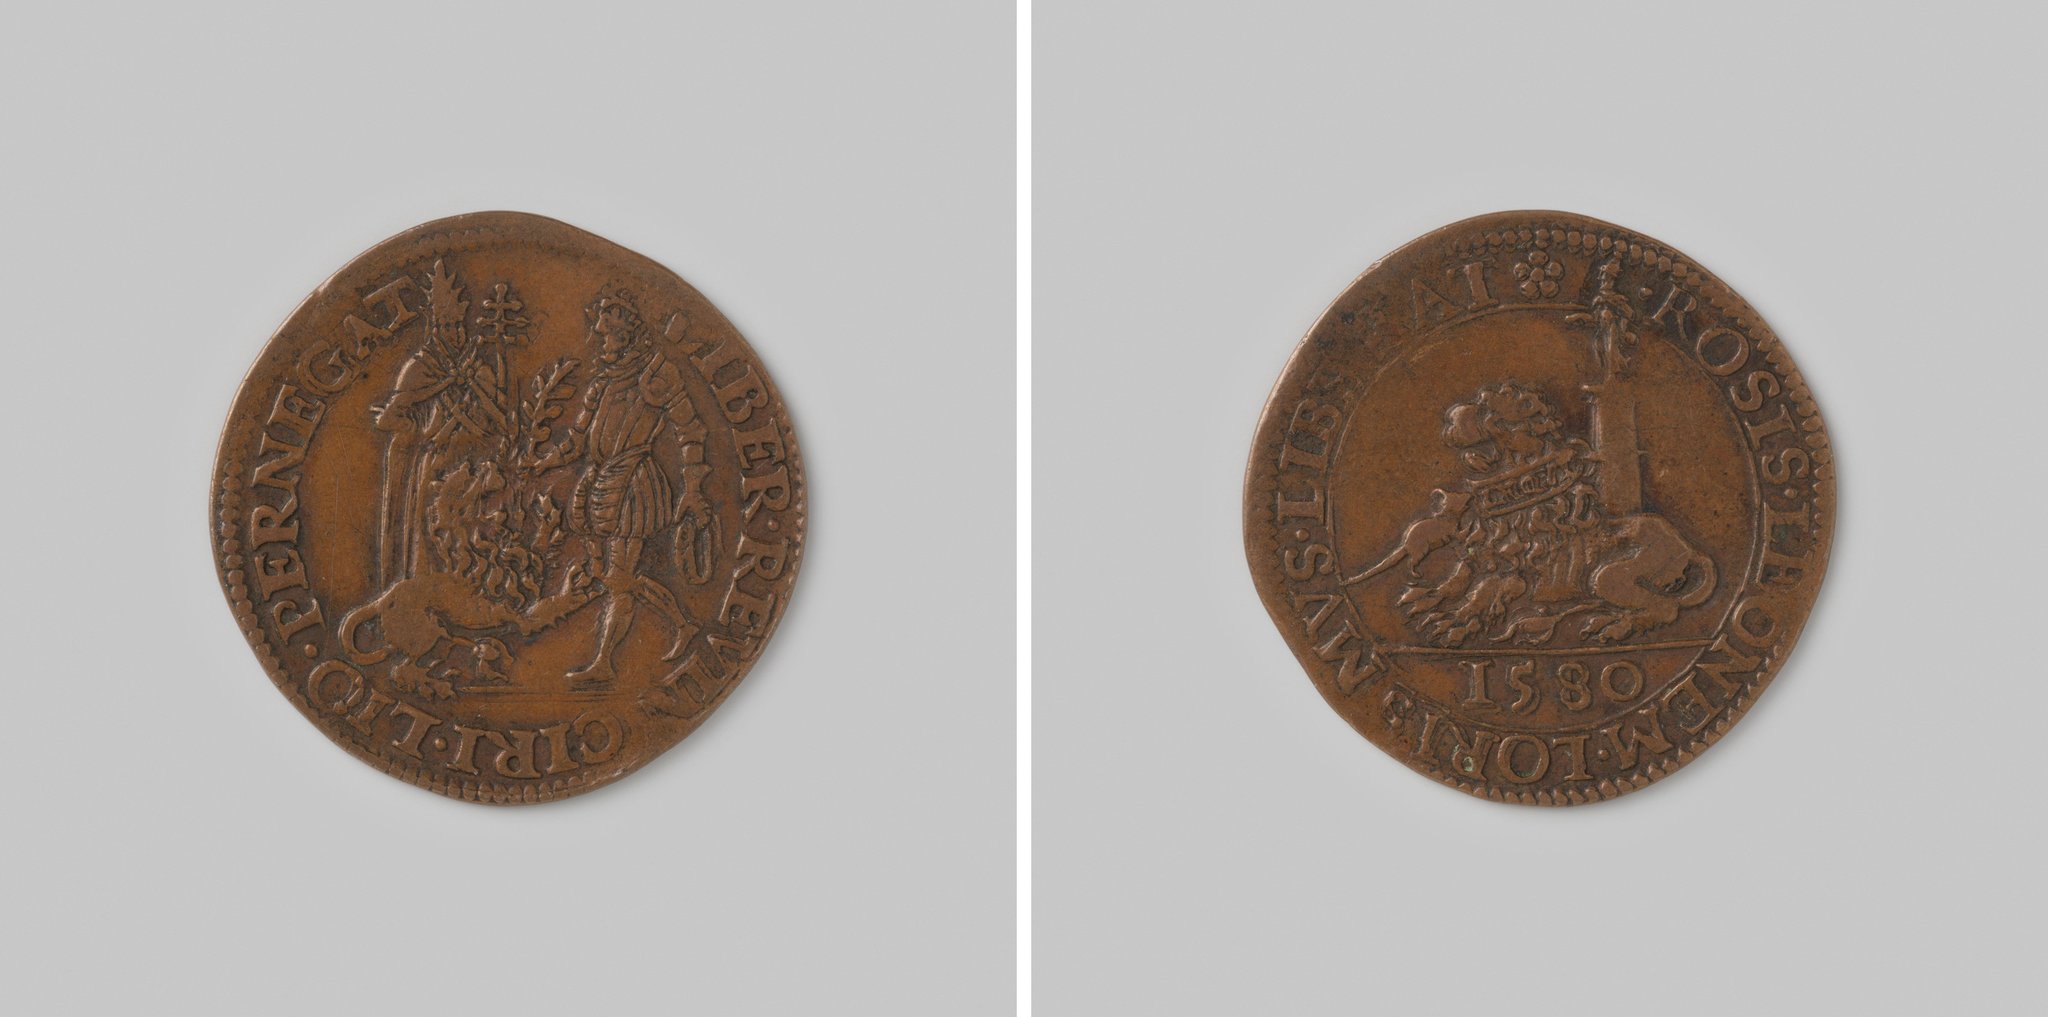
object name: history medal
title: Rekenpenning uit Dordrecht op de afgebroken vredesonderhandelingen te Keulen 1580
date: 1580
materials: copper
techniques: striking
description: Koperen penning, op de voorzijde de Spaanse Koning die een leeuw een olijftak aanbiedt maar een halsband achter zijn rug houdt, gezegend door de Paus, met omschrift, op de keerzijde een leeuw gekluisterd aan een zuil met een halsband, waar een rat aan knaagt, met afsnedetekst en omschrift.